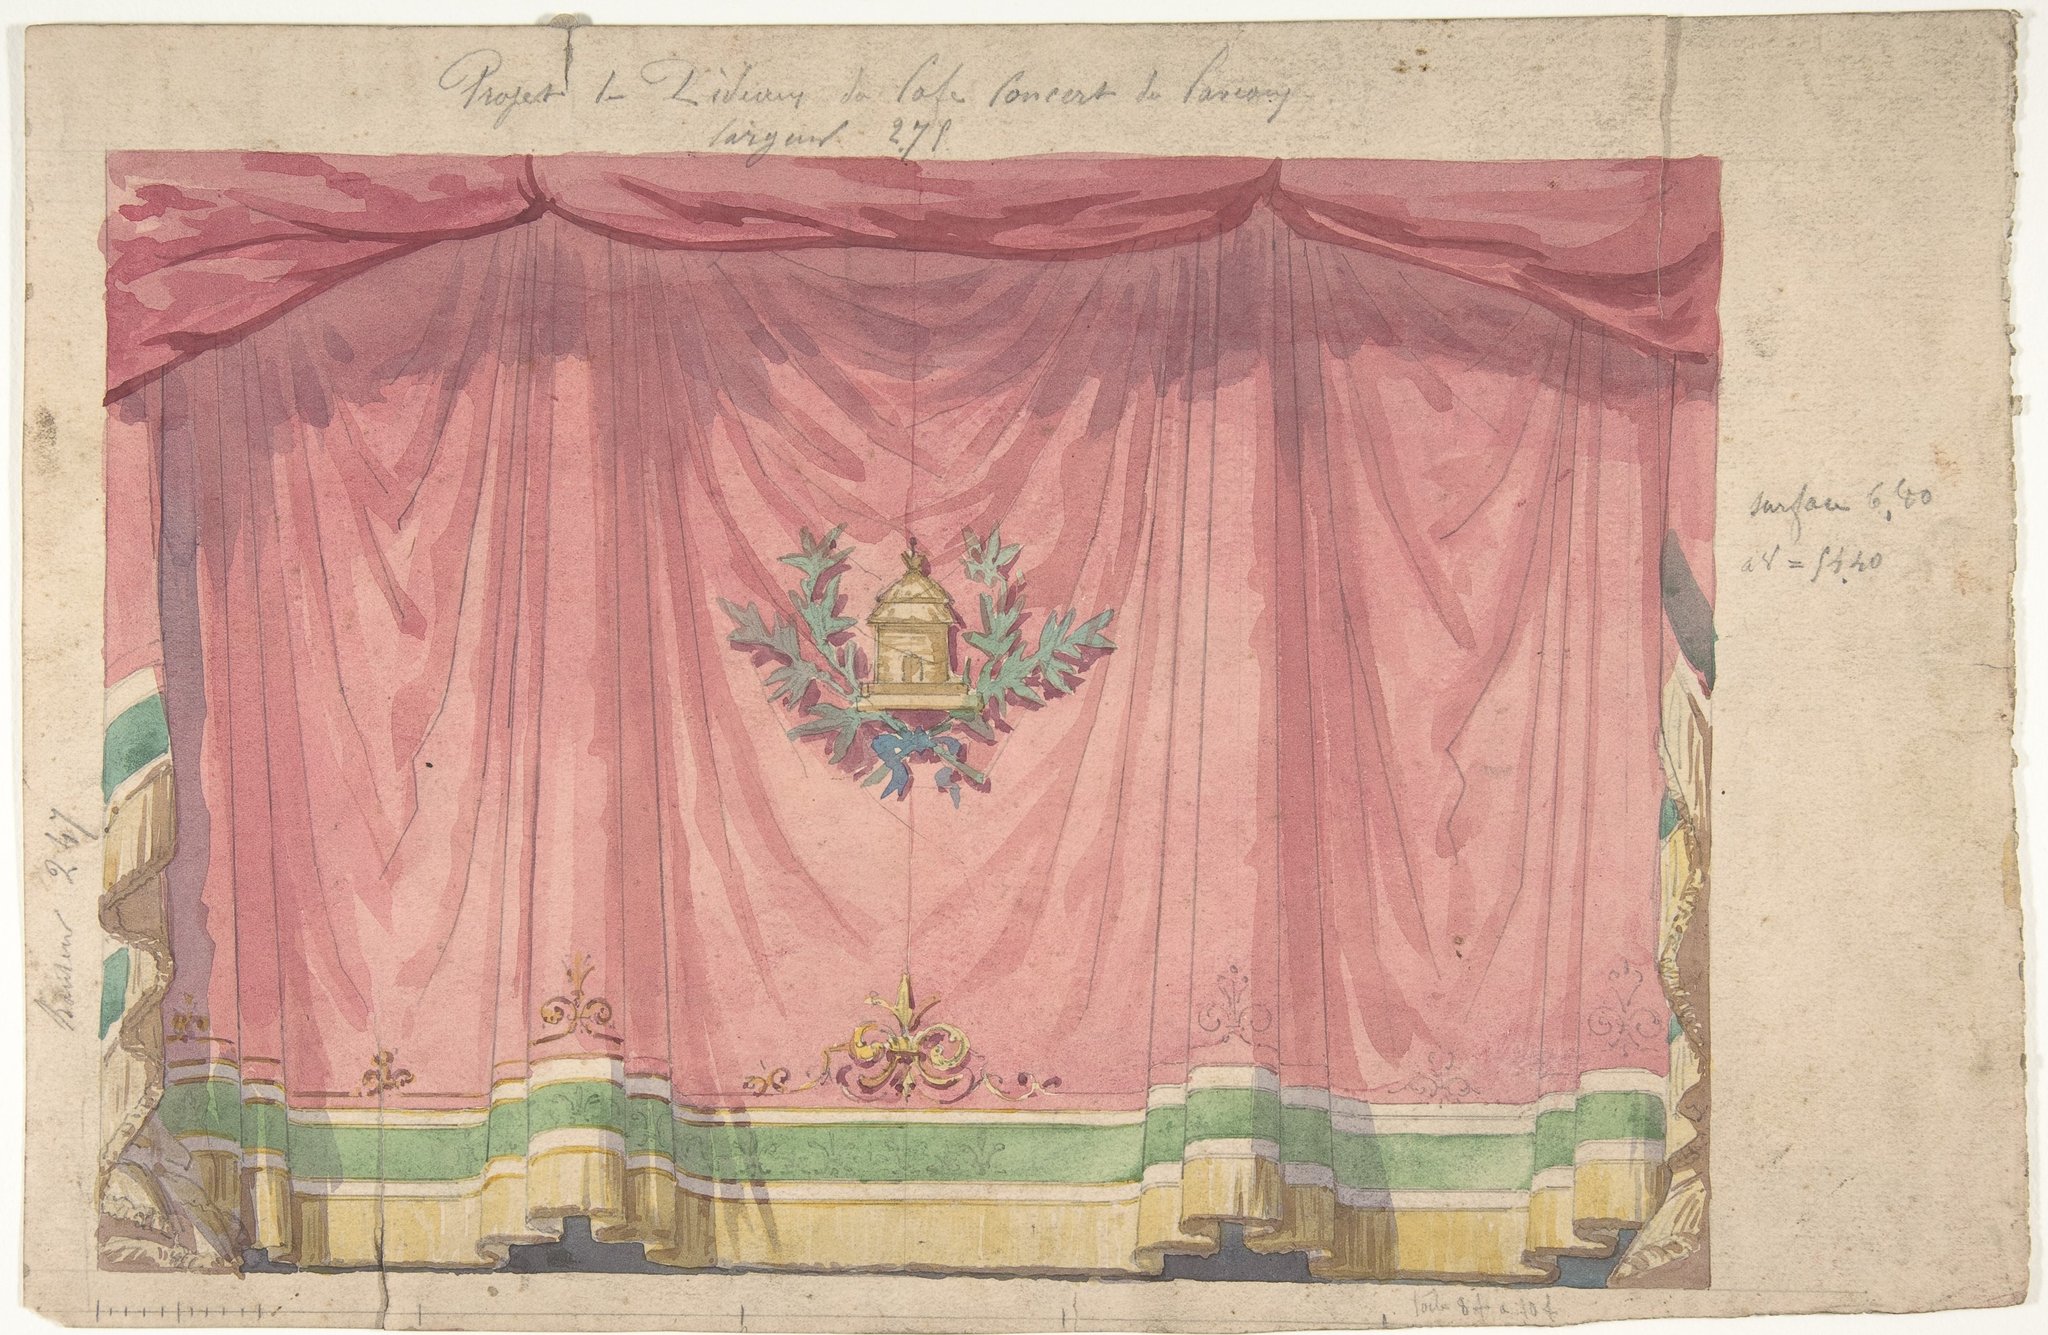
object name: drawing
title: Design for a Stage Curtain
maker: eugène cicéri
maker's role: artist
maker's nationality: french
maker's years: 1813-1890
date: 1830-1890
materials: graphite, watercolor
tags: theatre,curtains